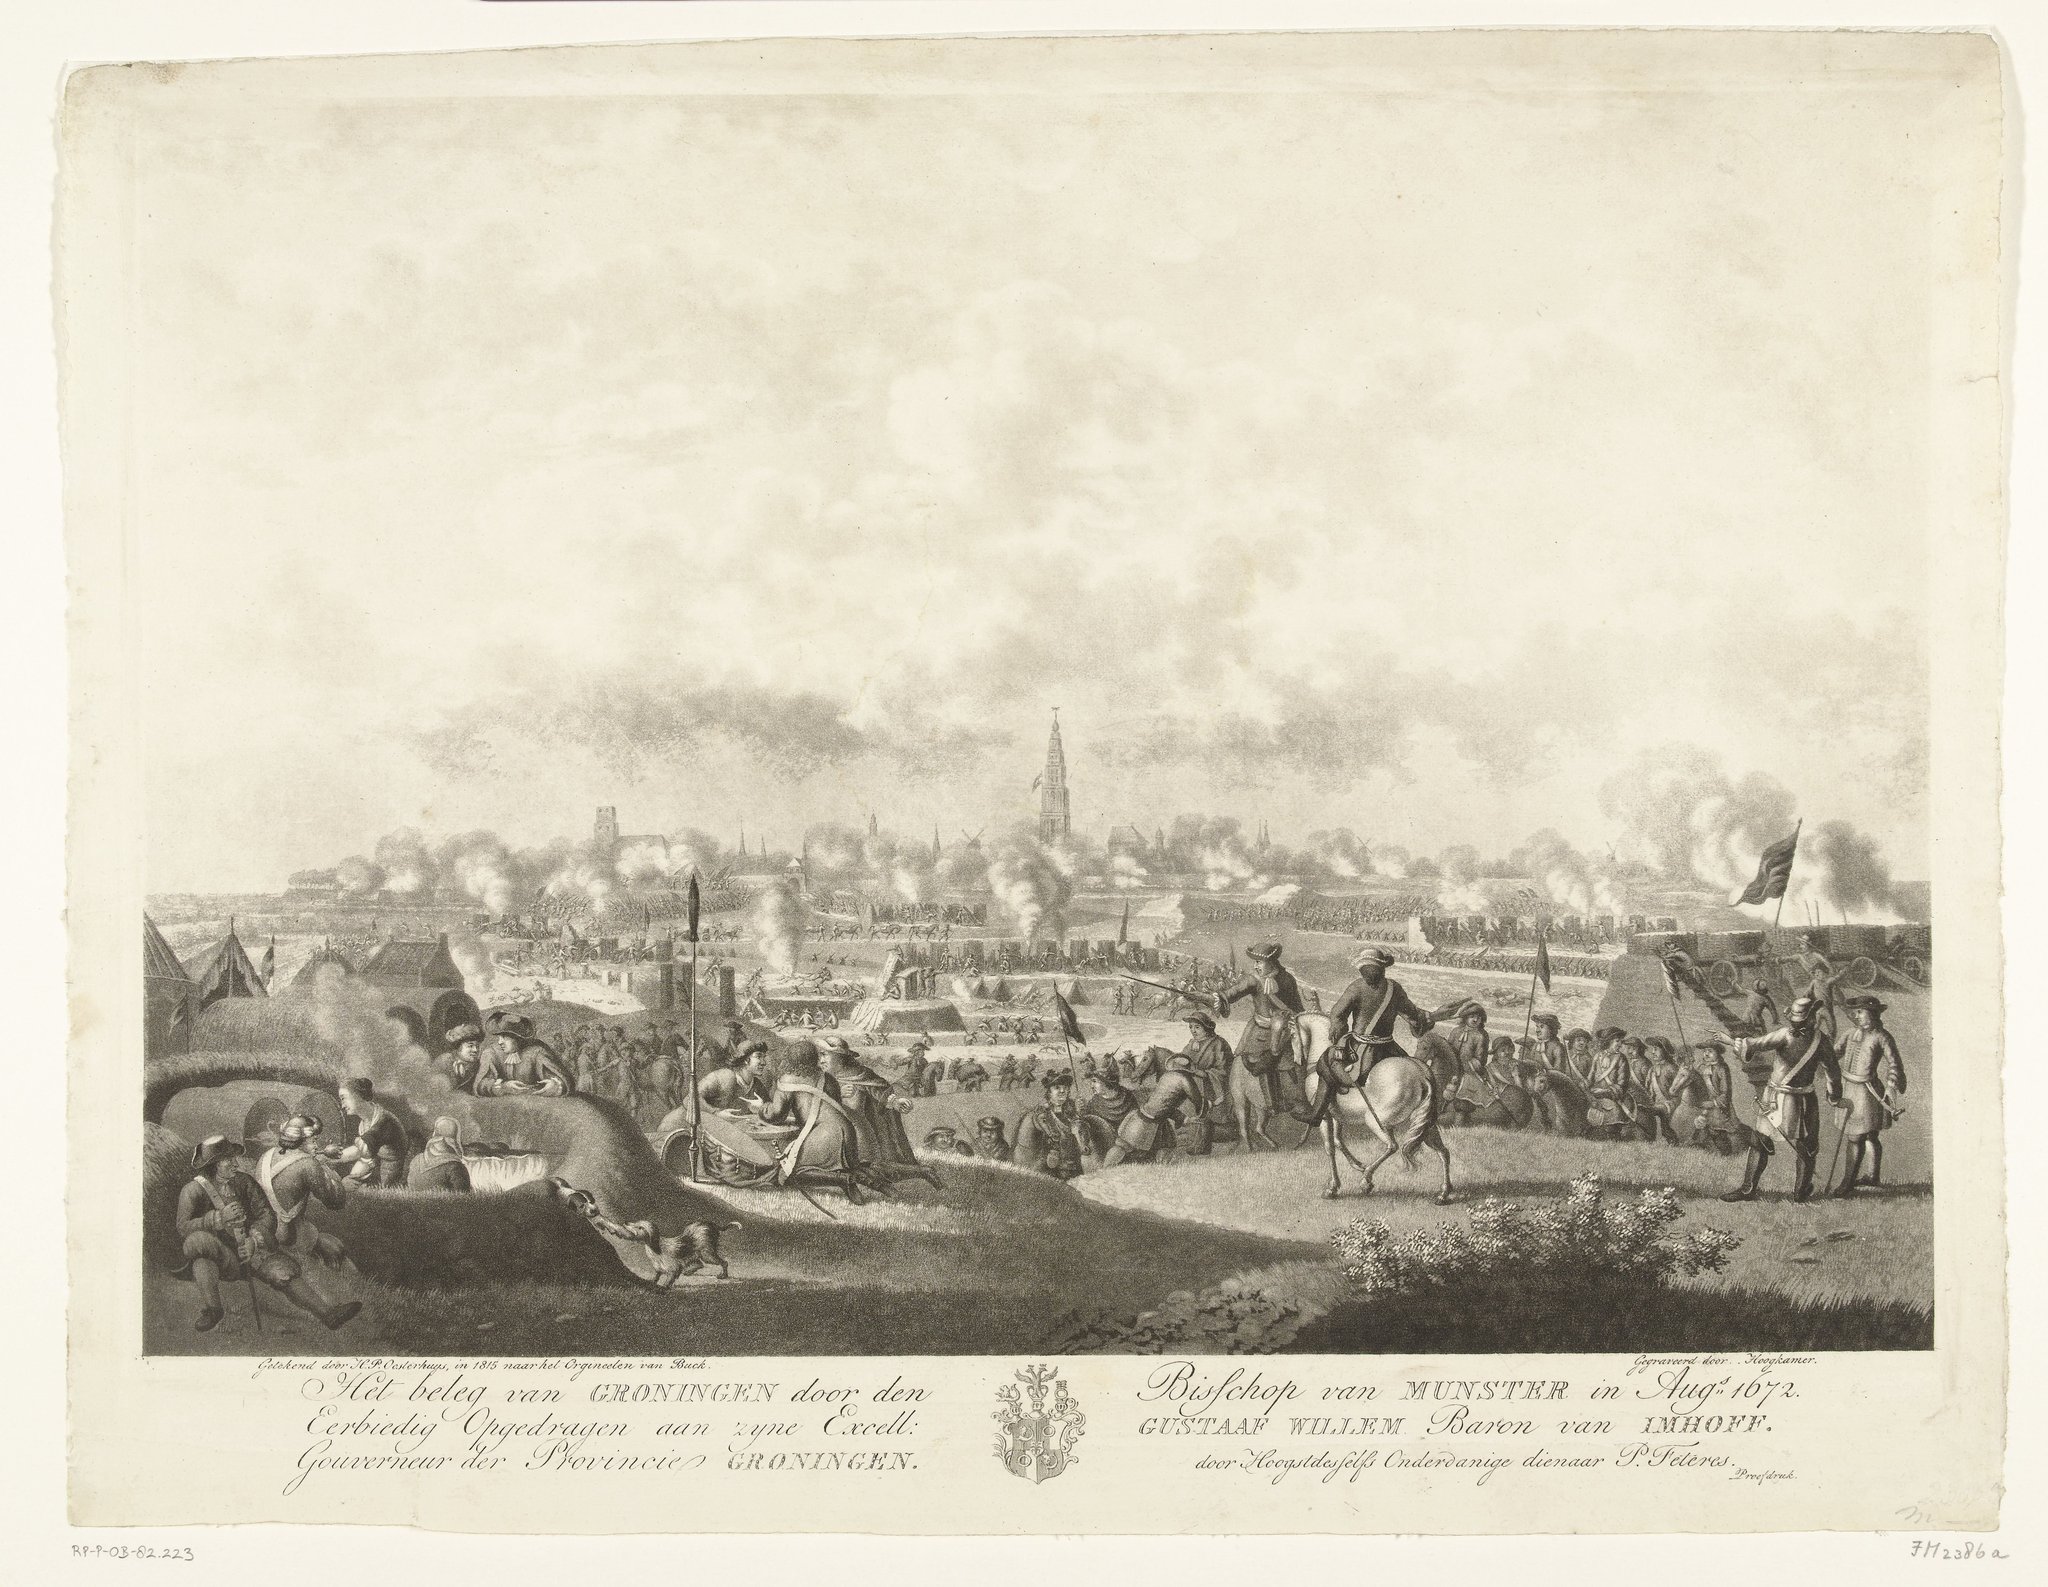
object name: history print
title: Het beleg van Groningen door den Bisschop van Munster in Aug.s 1672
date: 1815-1830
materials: paper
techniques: aquatint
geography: netherlands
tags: siege, position war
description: Het beleg van Groningen door de bisschoppen van Keulen en Munster gedurende de maanden juli en augustus van het jaar 1672. Gezicht op de stad vanuit het legerkamp van de belegeraars.